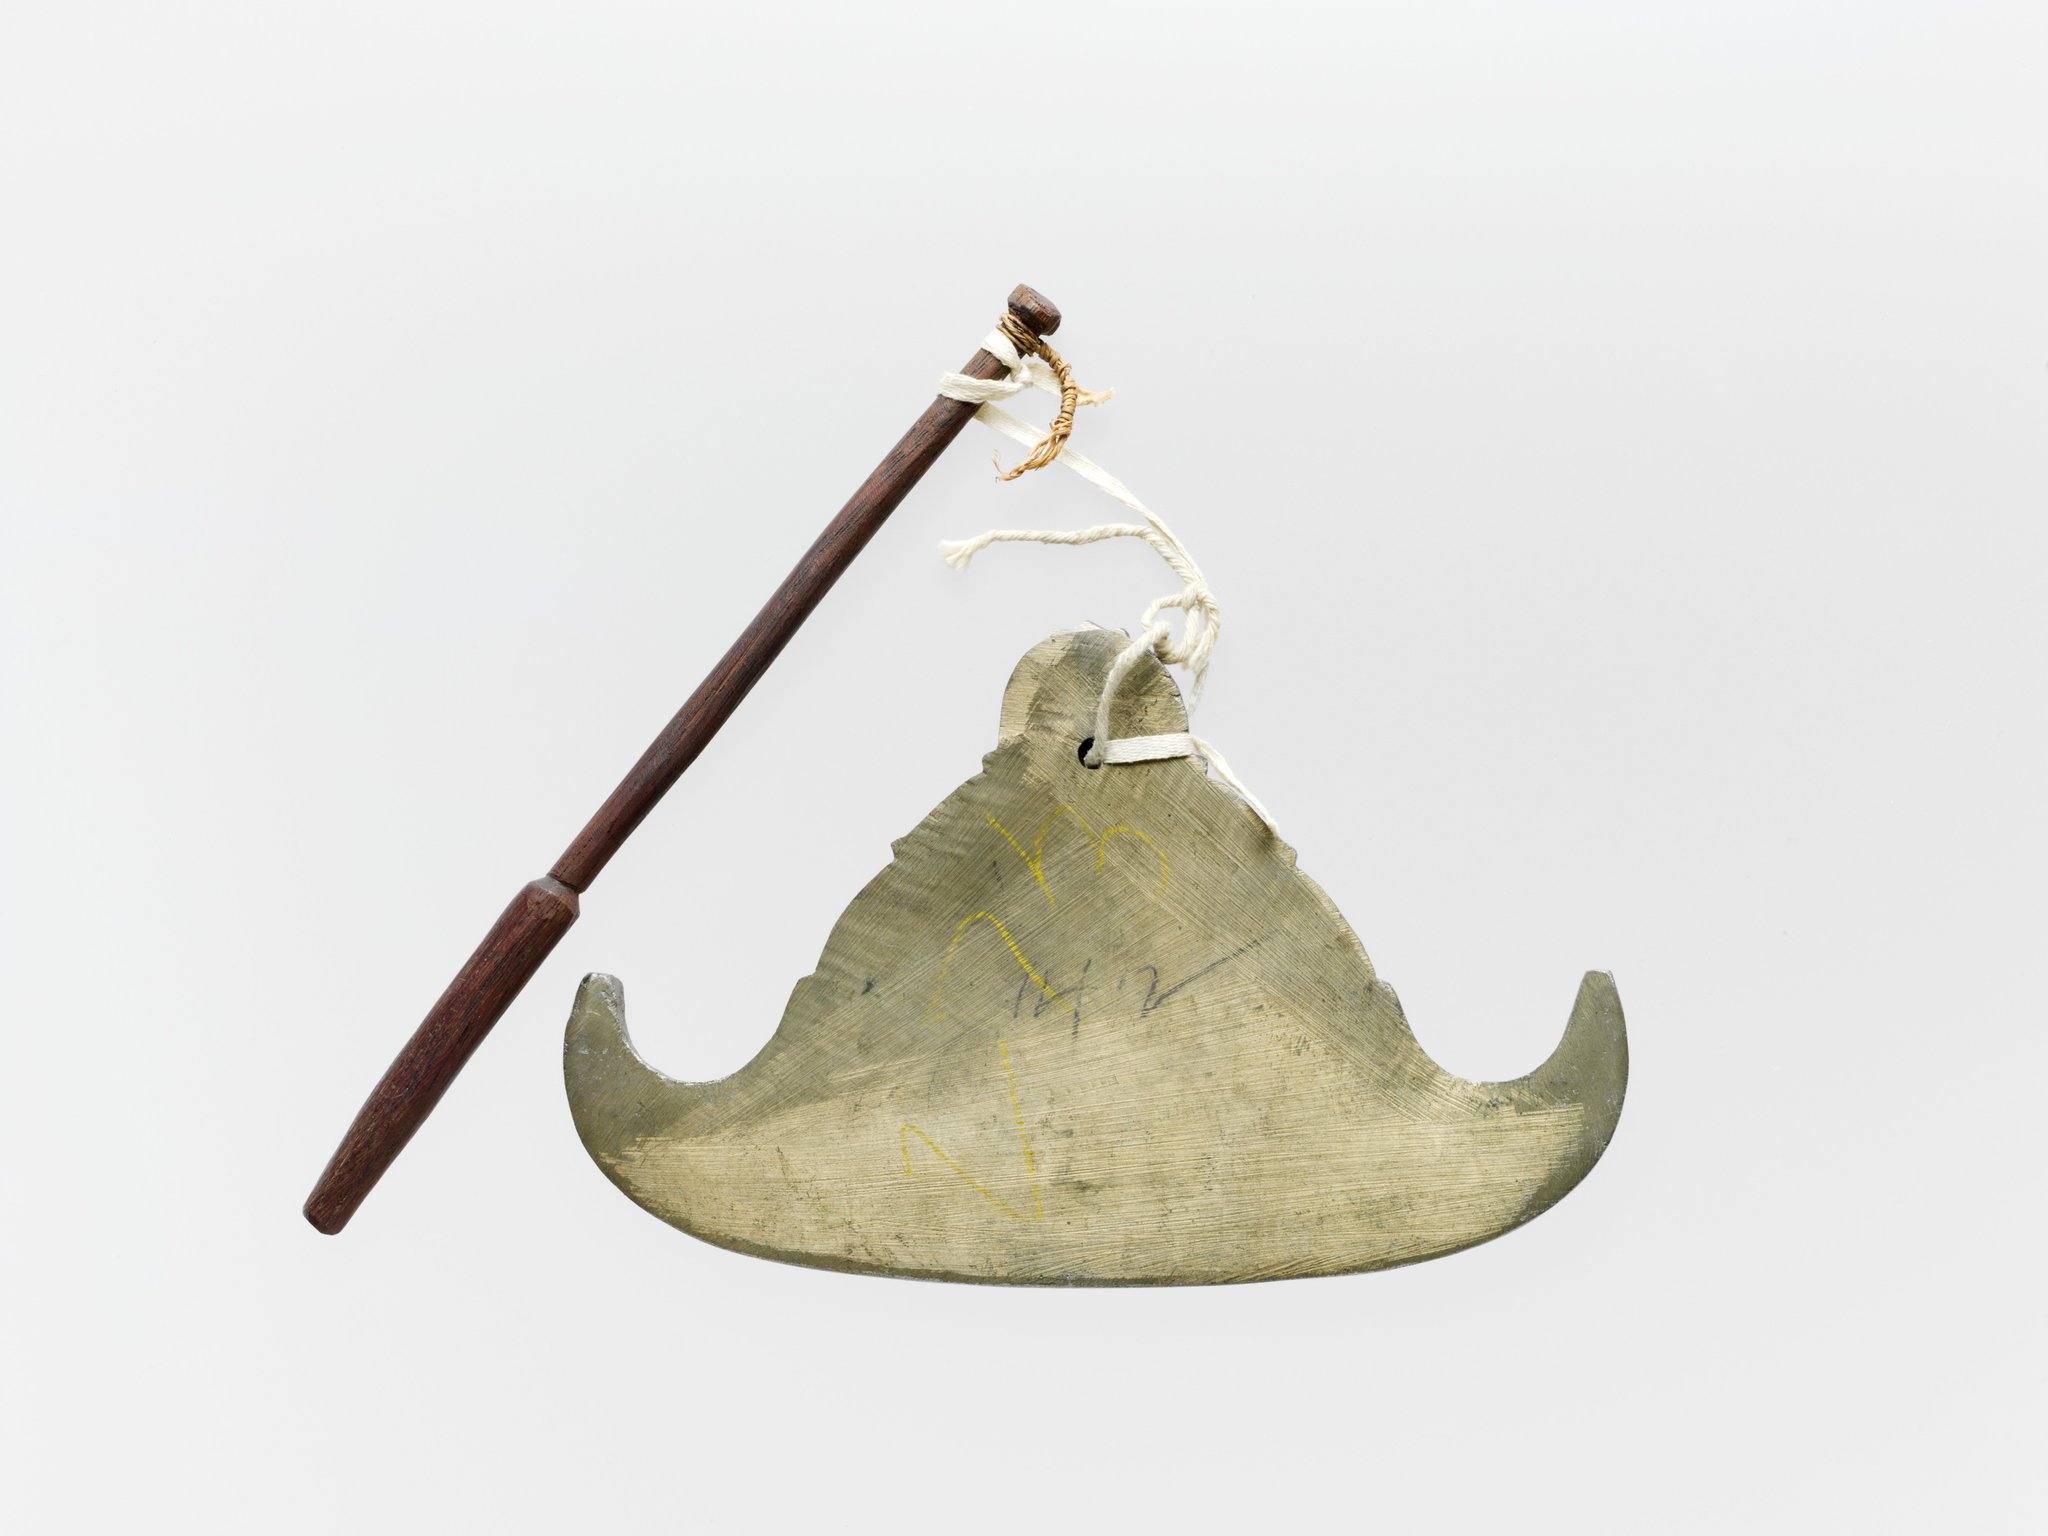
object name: la kang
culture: thai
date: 1867-1900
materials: bronze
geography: thailand